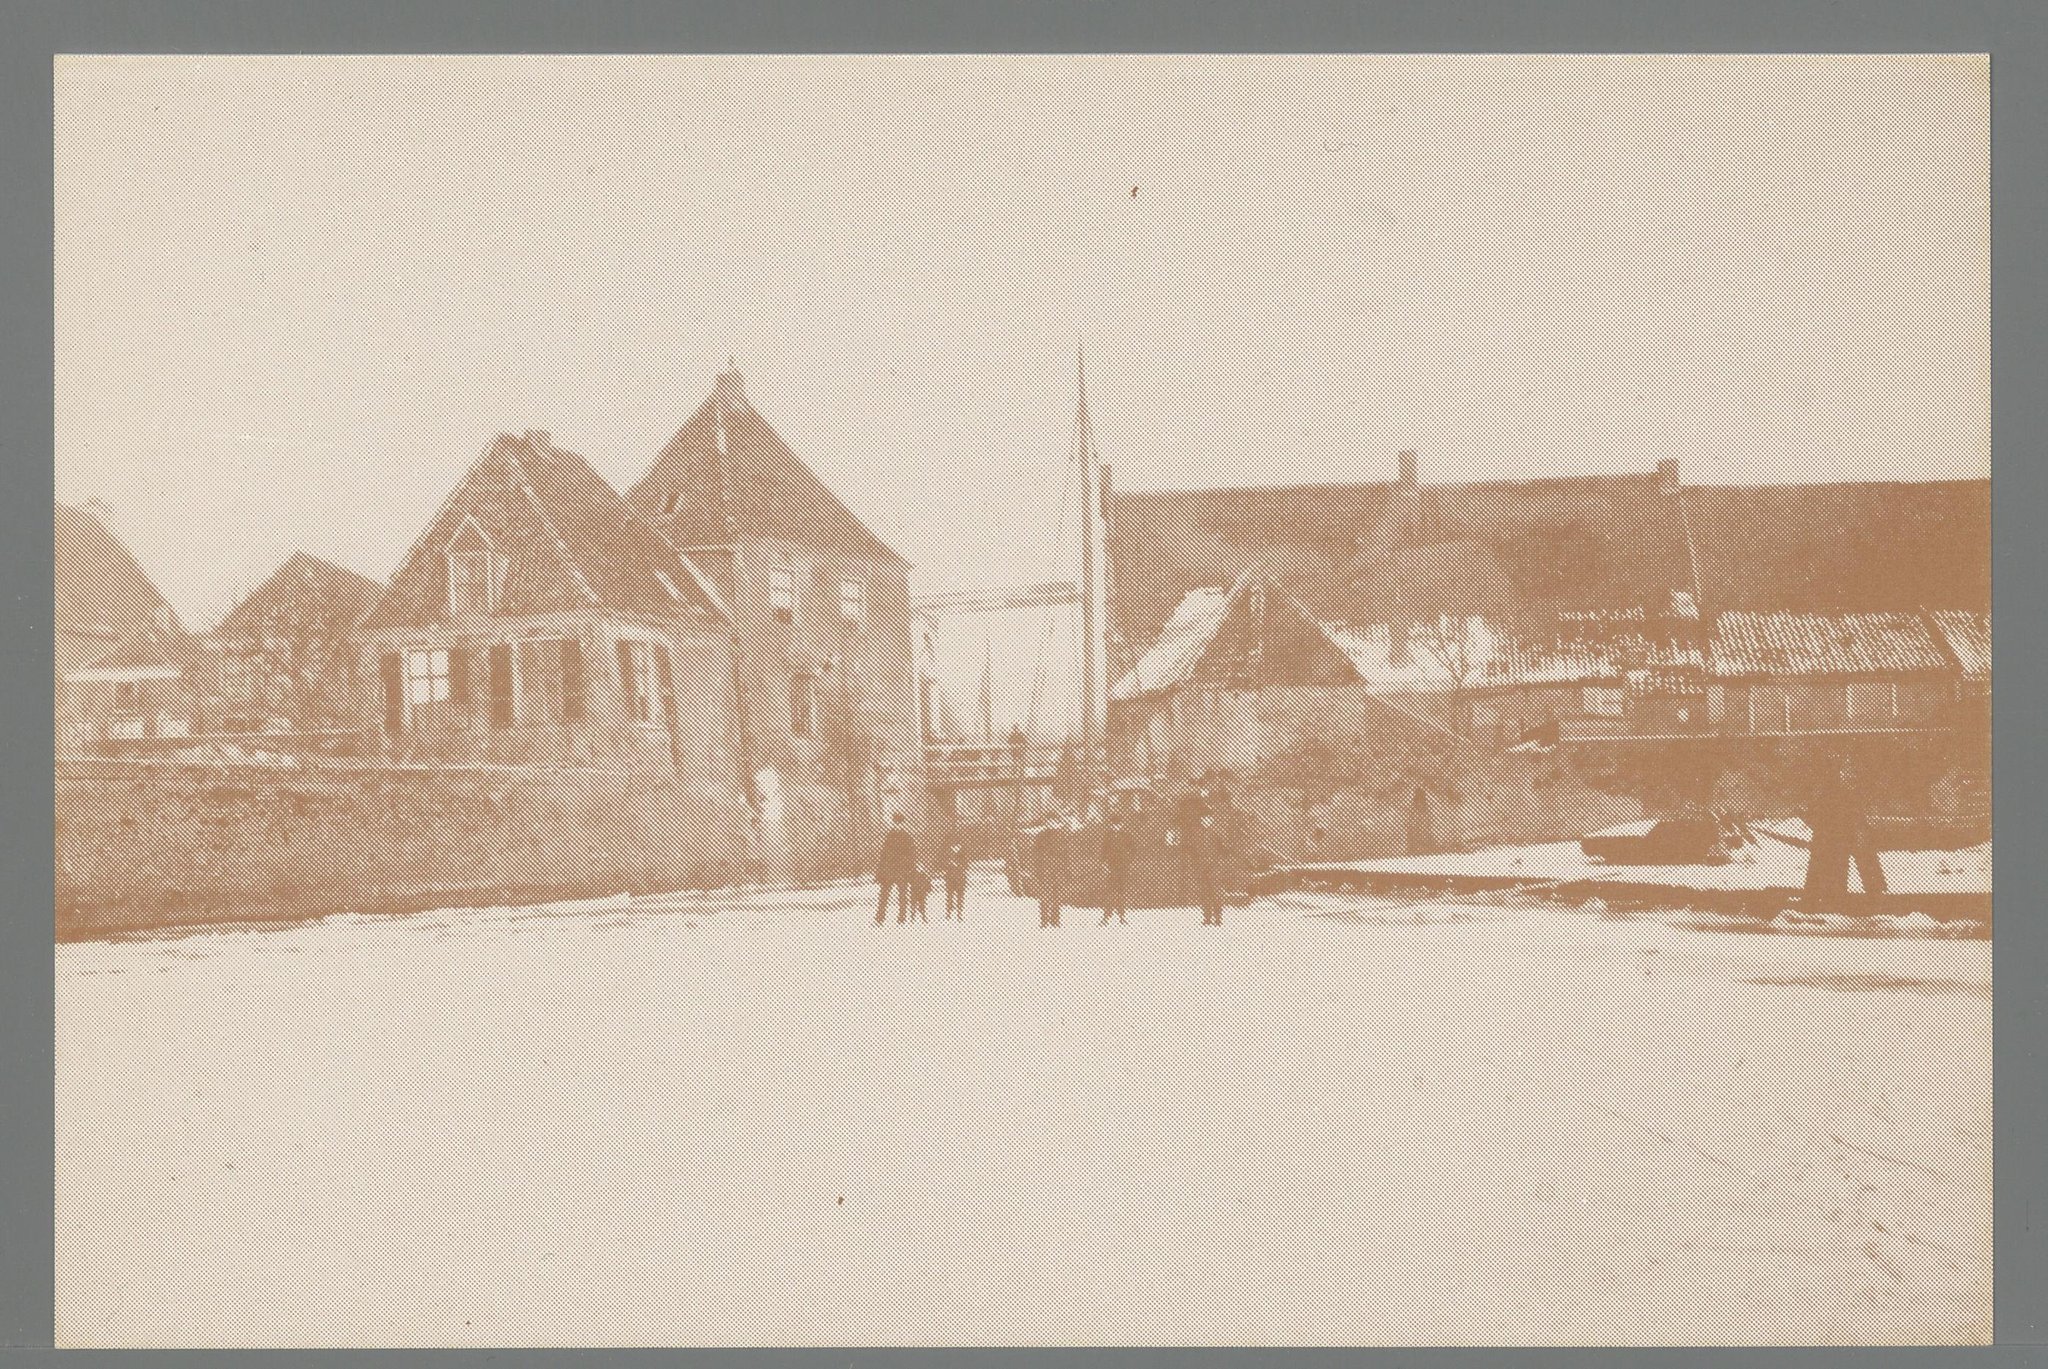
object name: photomechanical print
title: Ingang stadsgracht, 19e eeuw (Hasselt)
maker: Anonymous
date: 1958-2021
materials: cardboard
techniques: autotype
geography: hasselt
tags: city-view, and landscape with man-made constructions, canal, bridge